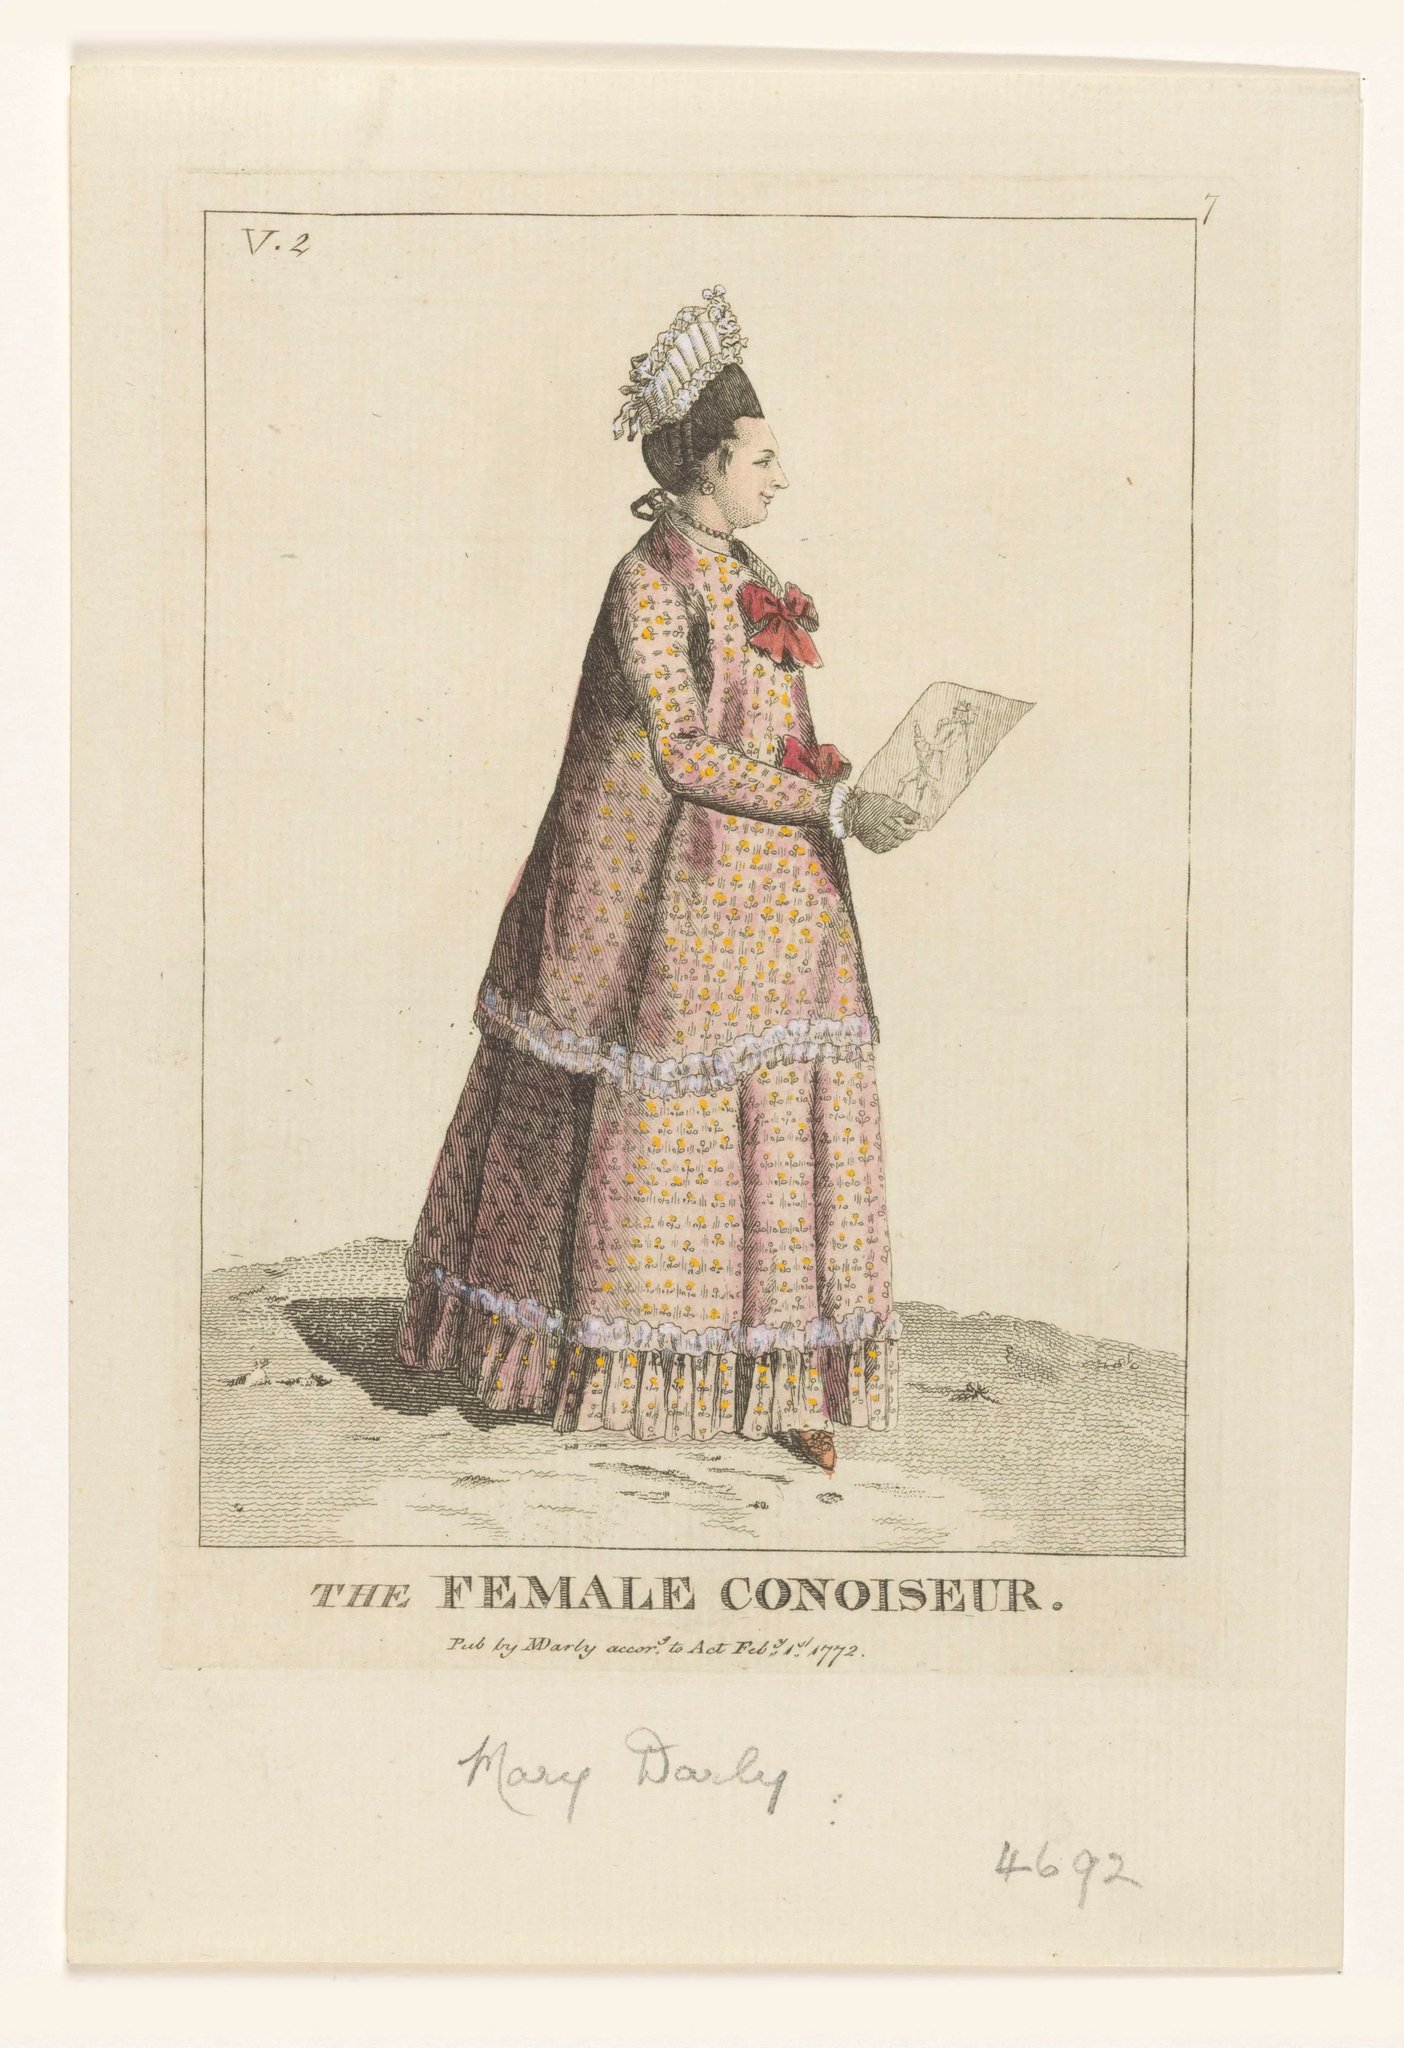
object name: print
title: The Female Conoiseur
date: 1702-1772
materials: paper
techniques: etching, hand coloring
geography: london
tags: draughtsman, mary darly, print, e.g.: engraving, etching, lithograph, publishing, publisher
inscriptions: collector's mark: Lugt 4780, collector's mark: Lugt 2228, annotation: ‘Mary Darly/ 4692’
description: Waarschijnlijk stelt de vrouw kunstenaar en uitgever Mary Darly voor, de tweede vrouw van Matthew Darly. Afkomstig uit de tweede serie van zes, getiteld: Macaronies, Characters, Caricatures &c., uitgegeven door Matthew Darly in Londen tussen 1771 en 1773. De term 'macaroni' werd gebruikt in Engeland in de tweede helft van de 18de eeuw voor personen die op een overdreven wijze de laatste mode volgden. In zekere zin vormden zij de voorlopers van de dandy's.